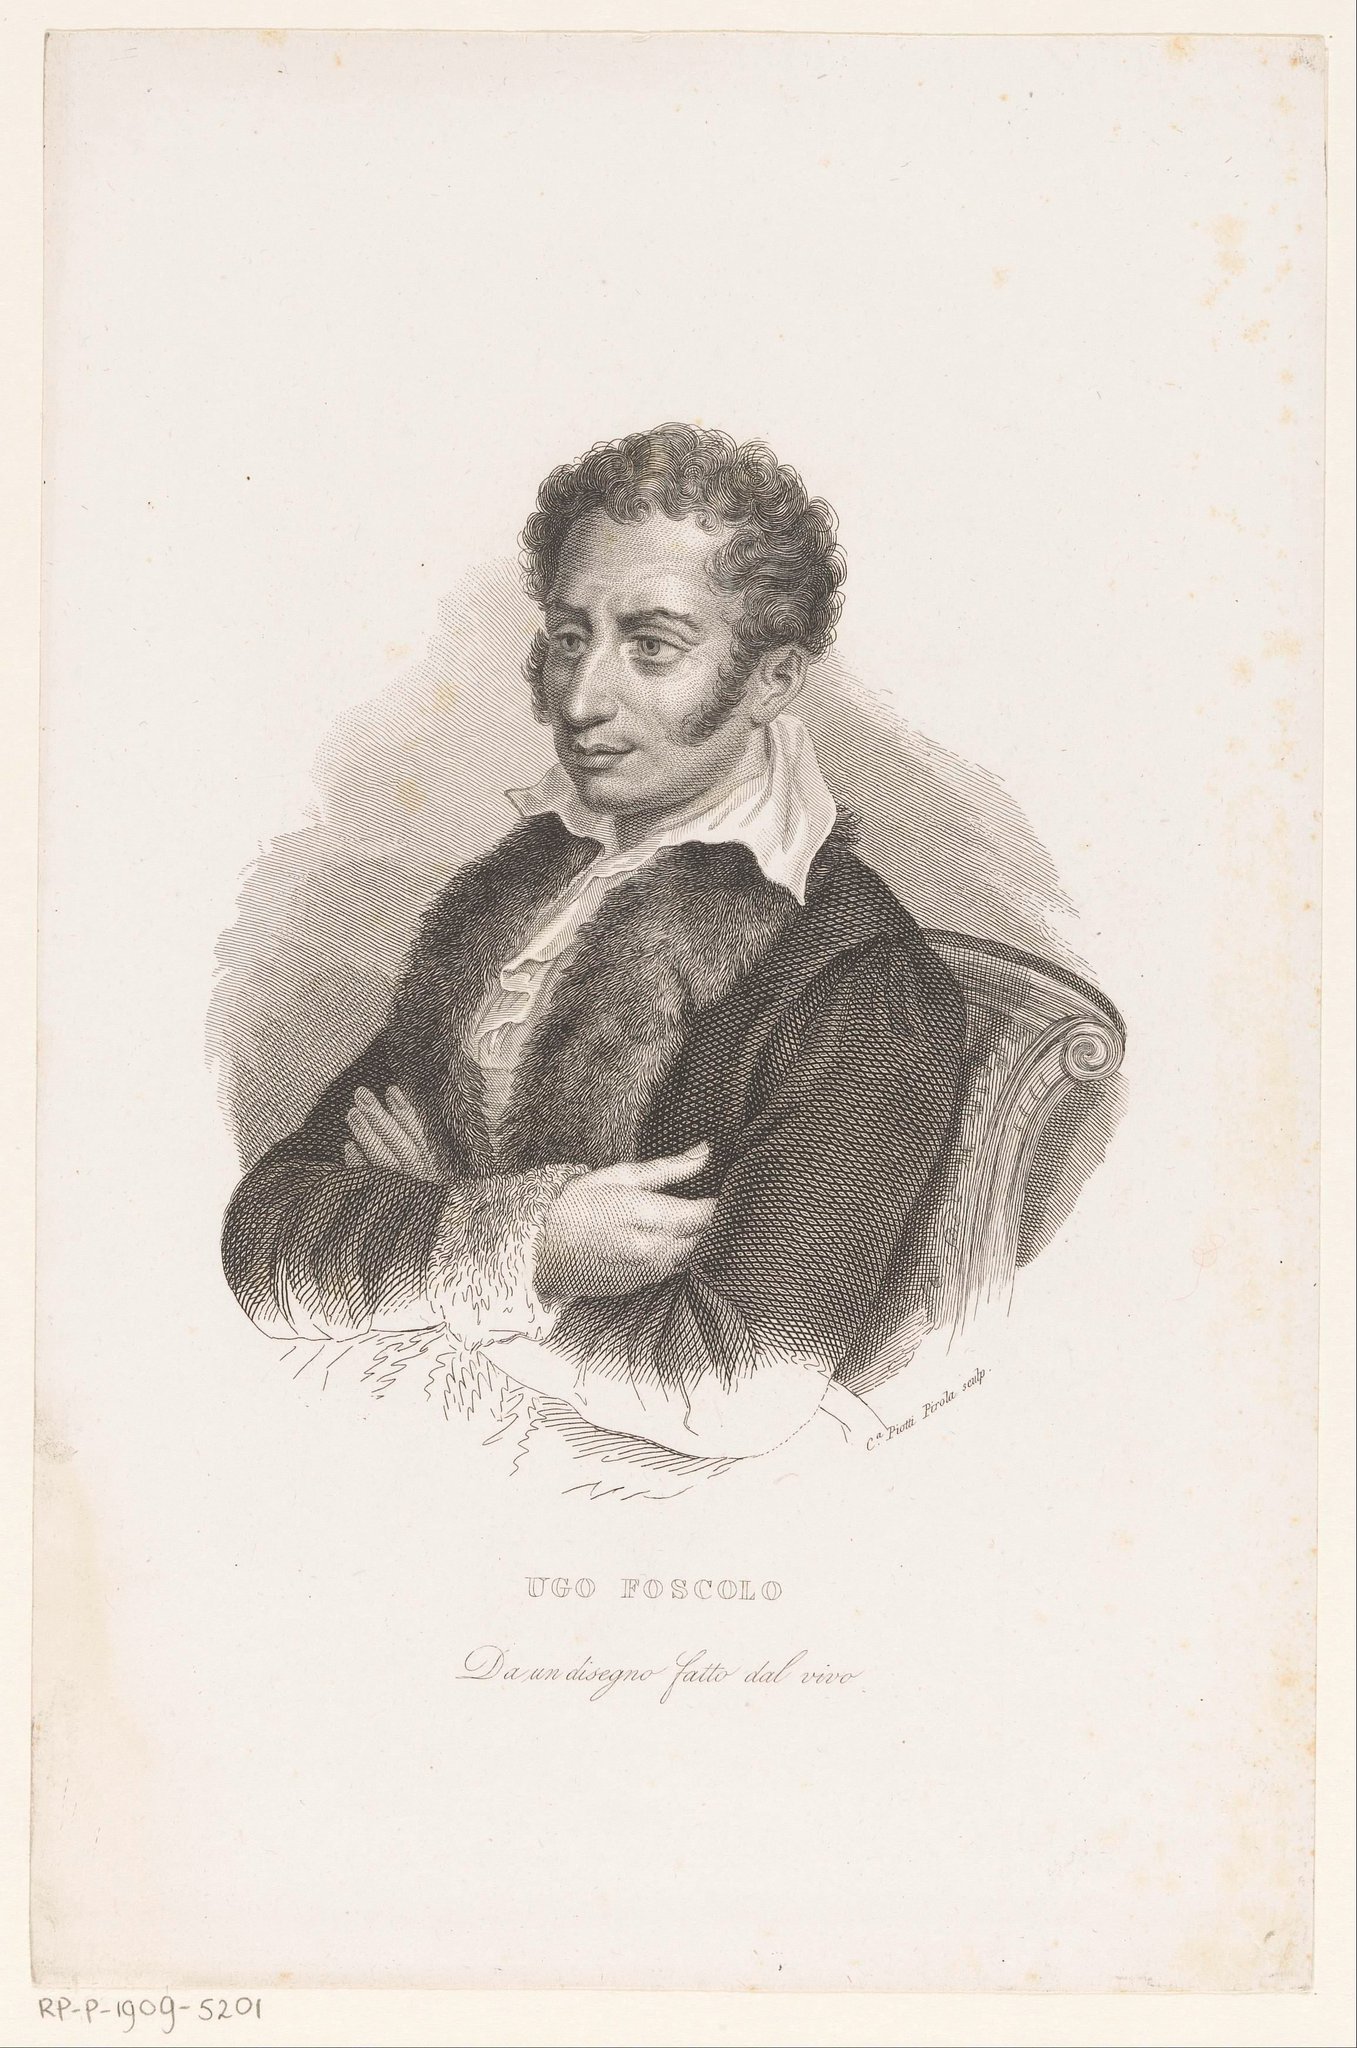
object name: print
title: Portret van schrijver Ugo Foscolo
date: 1810-1900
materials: paper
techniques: engraving, etching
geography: italy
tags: london, historical persons, writer, poet, author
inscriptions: collector's mark: Lugt 2228